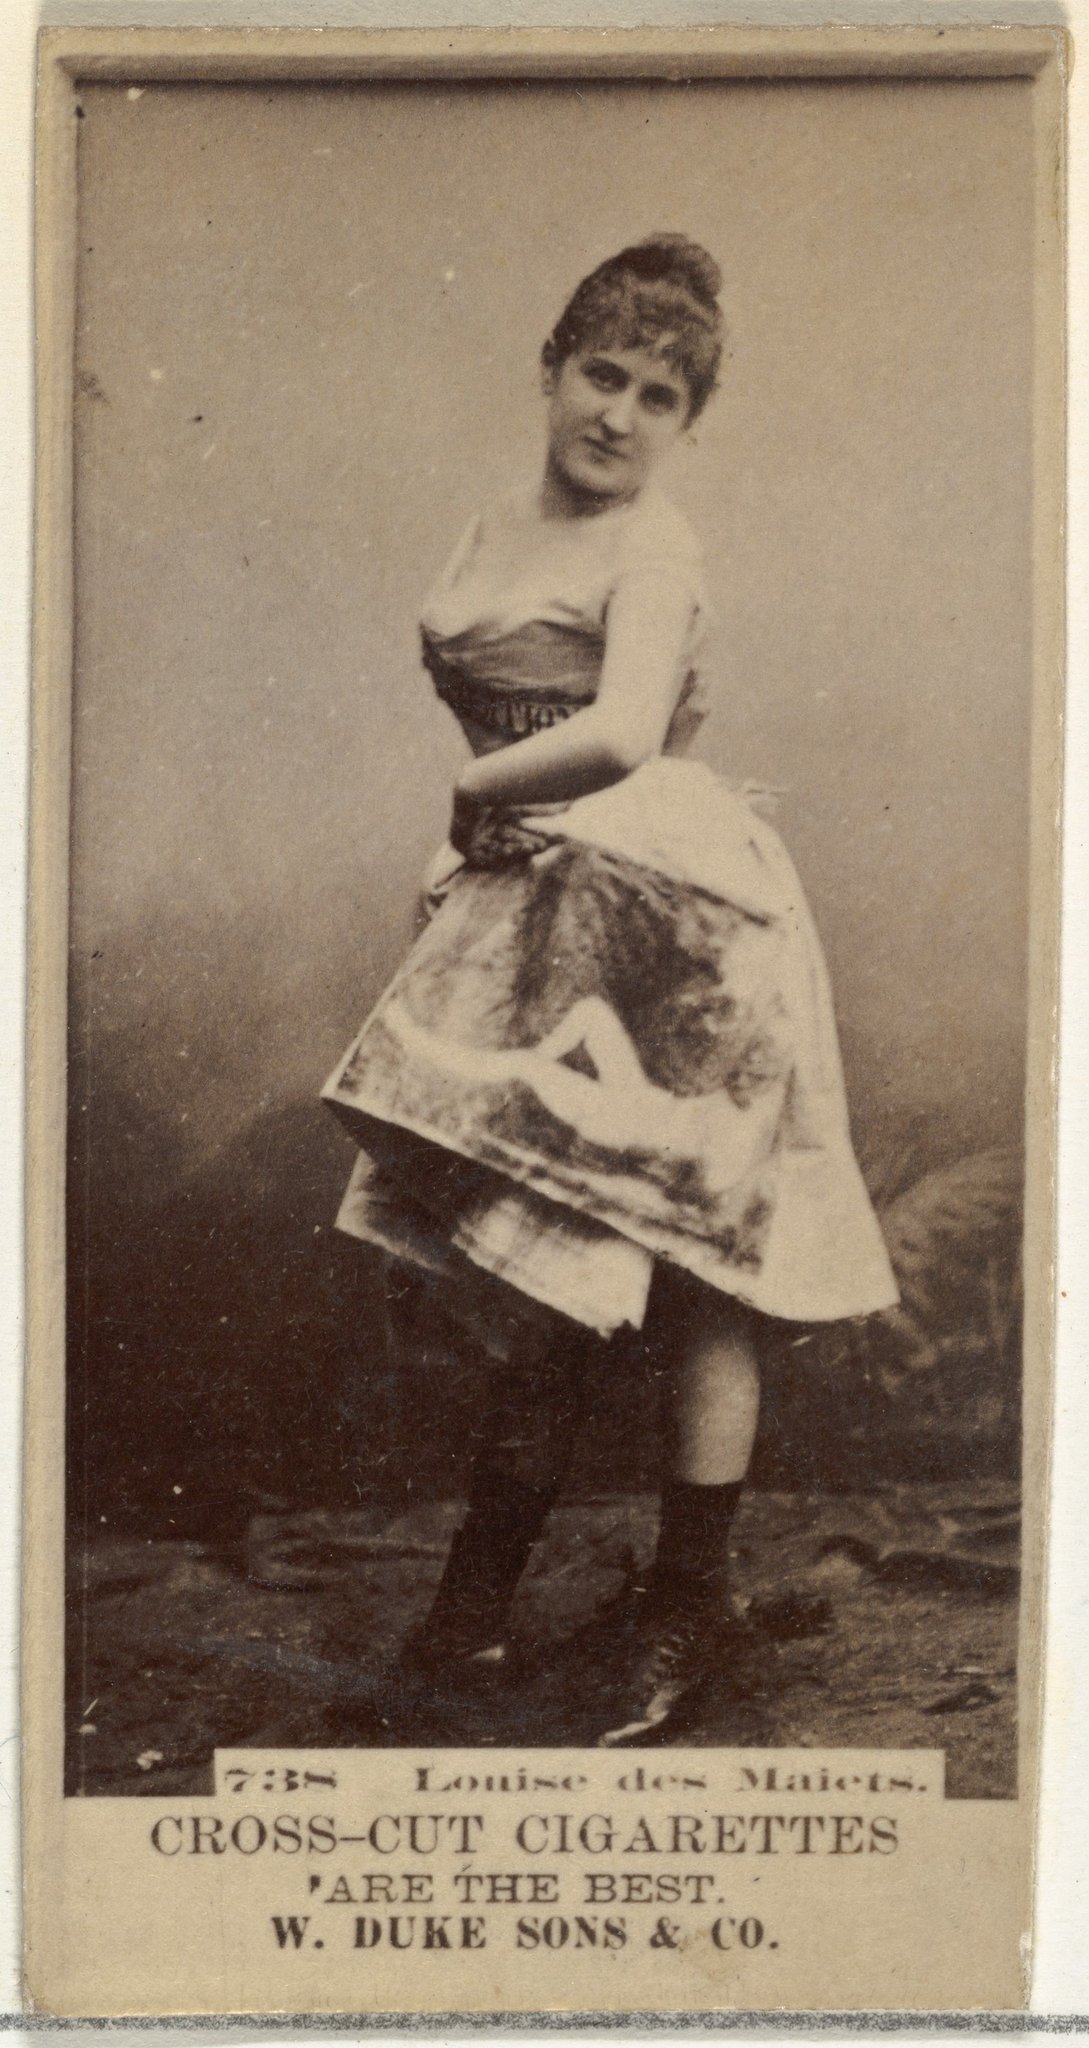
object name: photograph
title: Card Number 738, Louise des Maiets, from the Actors and Actresses series (N145-3) issued by Duke Sons & Co. to promote Cross Cut Cigarettes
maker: w. duke, sons & co.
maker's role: publisher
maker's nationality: american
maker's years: 1870-1920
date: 1880-1889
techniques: albumen silver print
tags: portraits,women,actresses